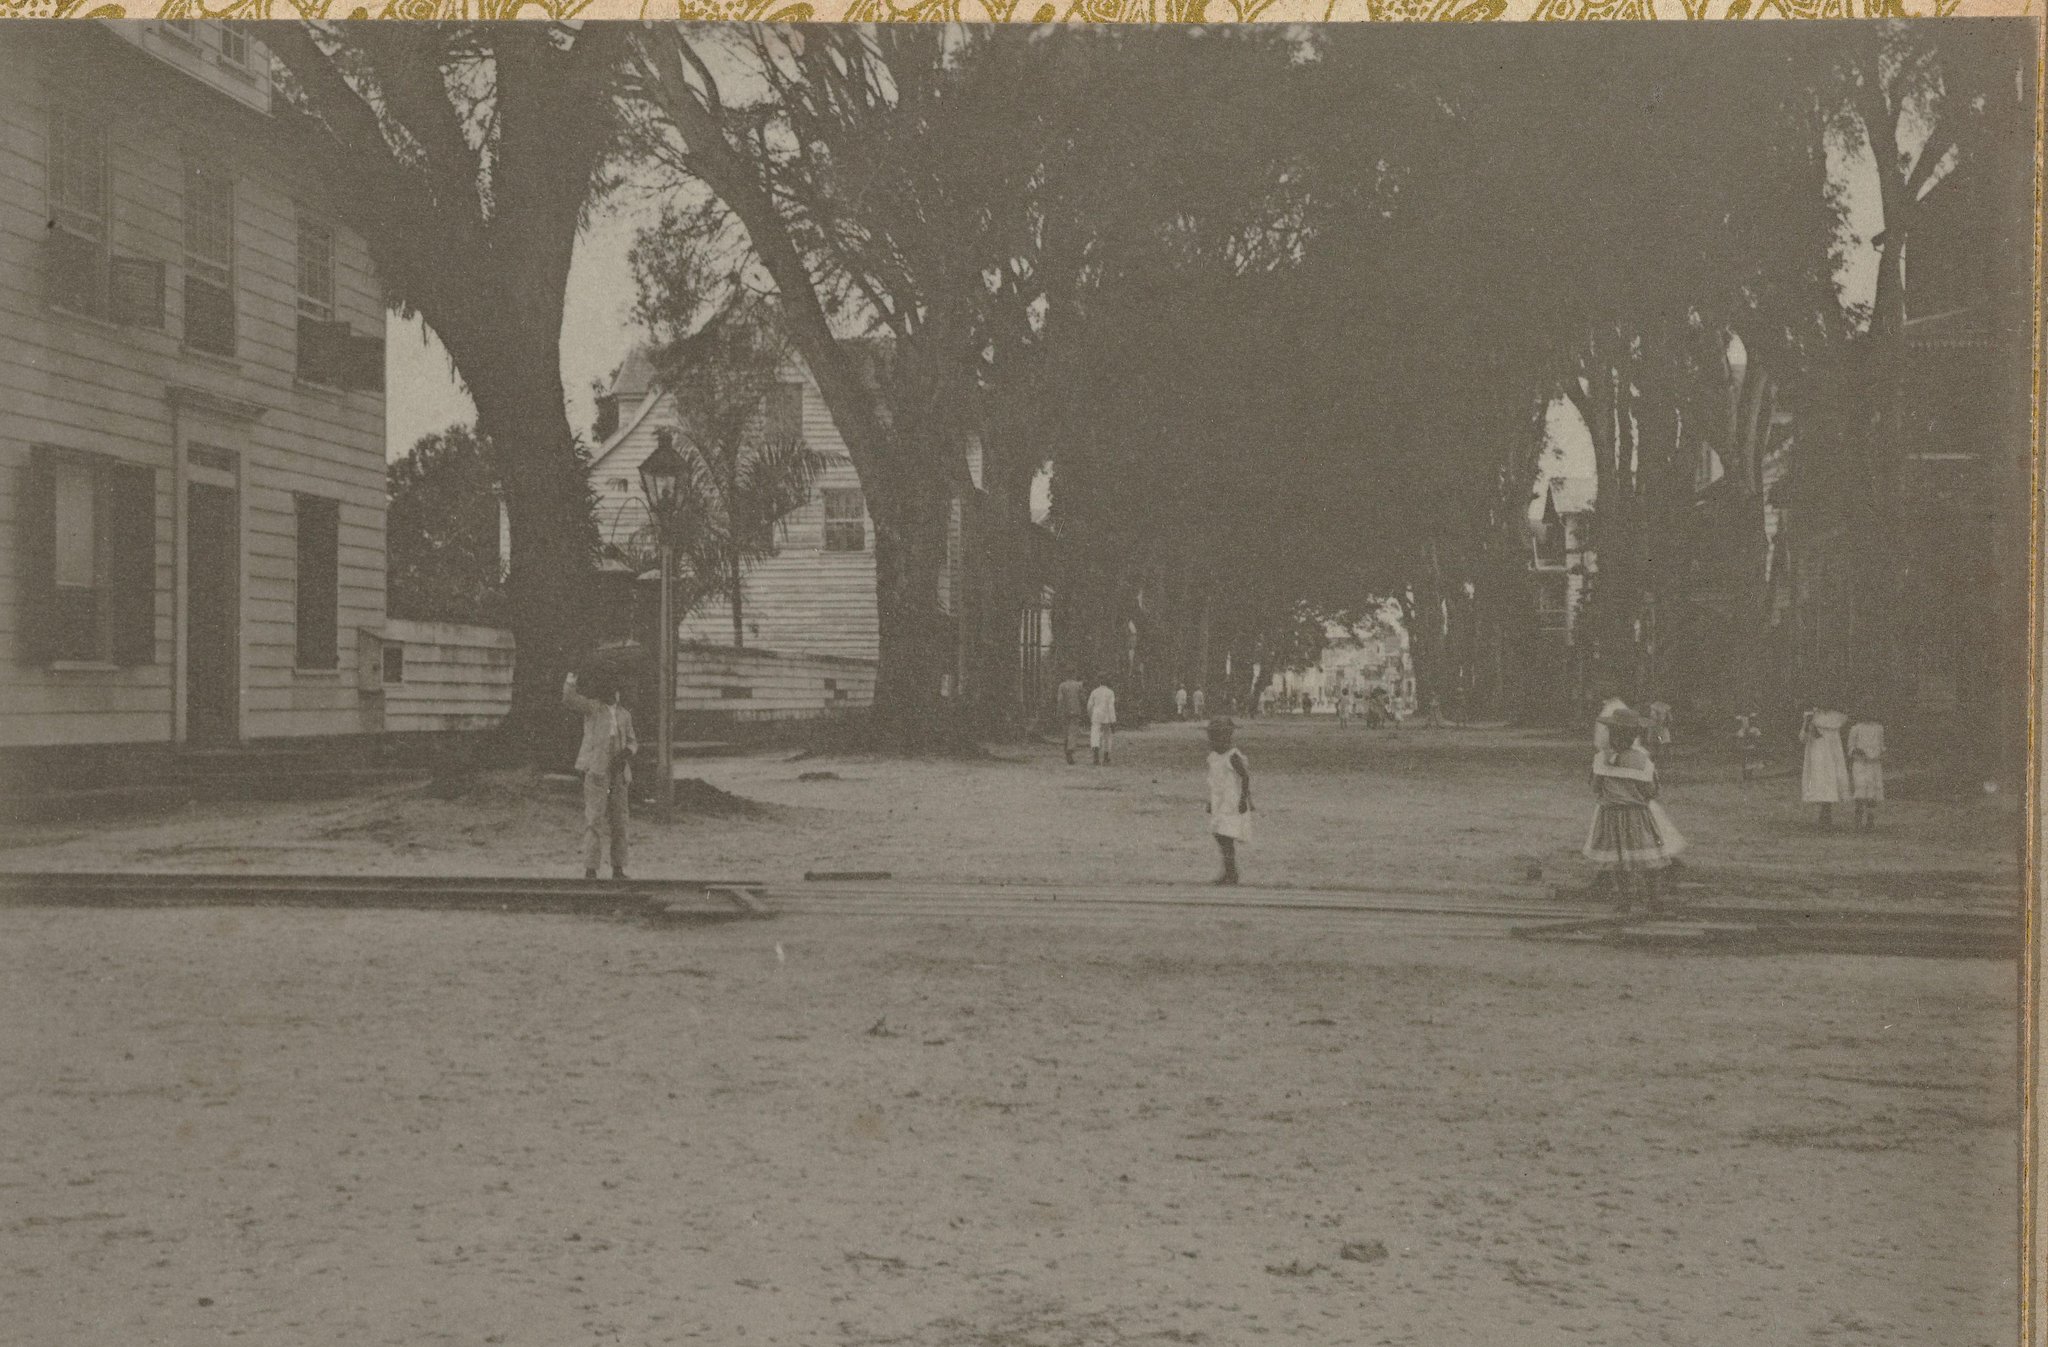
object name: photograph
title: Heerenstraat te Paramaribo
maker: hendrik doijer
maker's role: engineer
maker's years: 1863-1925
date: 1903-1910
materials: photographic support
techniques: gelatin silver print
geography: suriname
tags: suriname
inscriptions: inscription: ‘58’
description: Gezicht in de Heerenstraat te Paramaribo, met enkele mensen op straat. Onderdeel van het fotoalbum Souvenir de Voyage (deel 2), over het leven van de familie Doijer in en rond de plantage Ma Retraite in Suriname in de jaren 1903-1910.